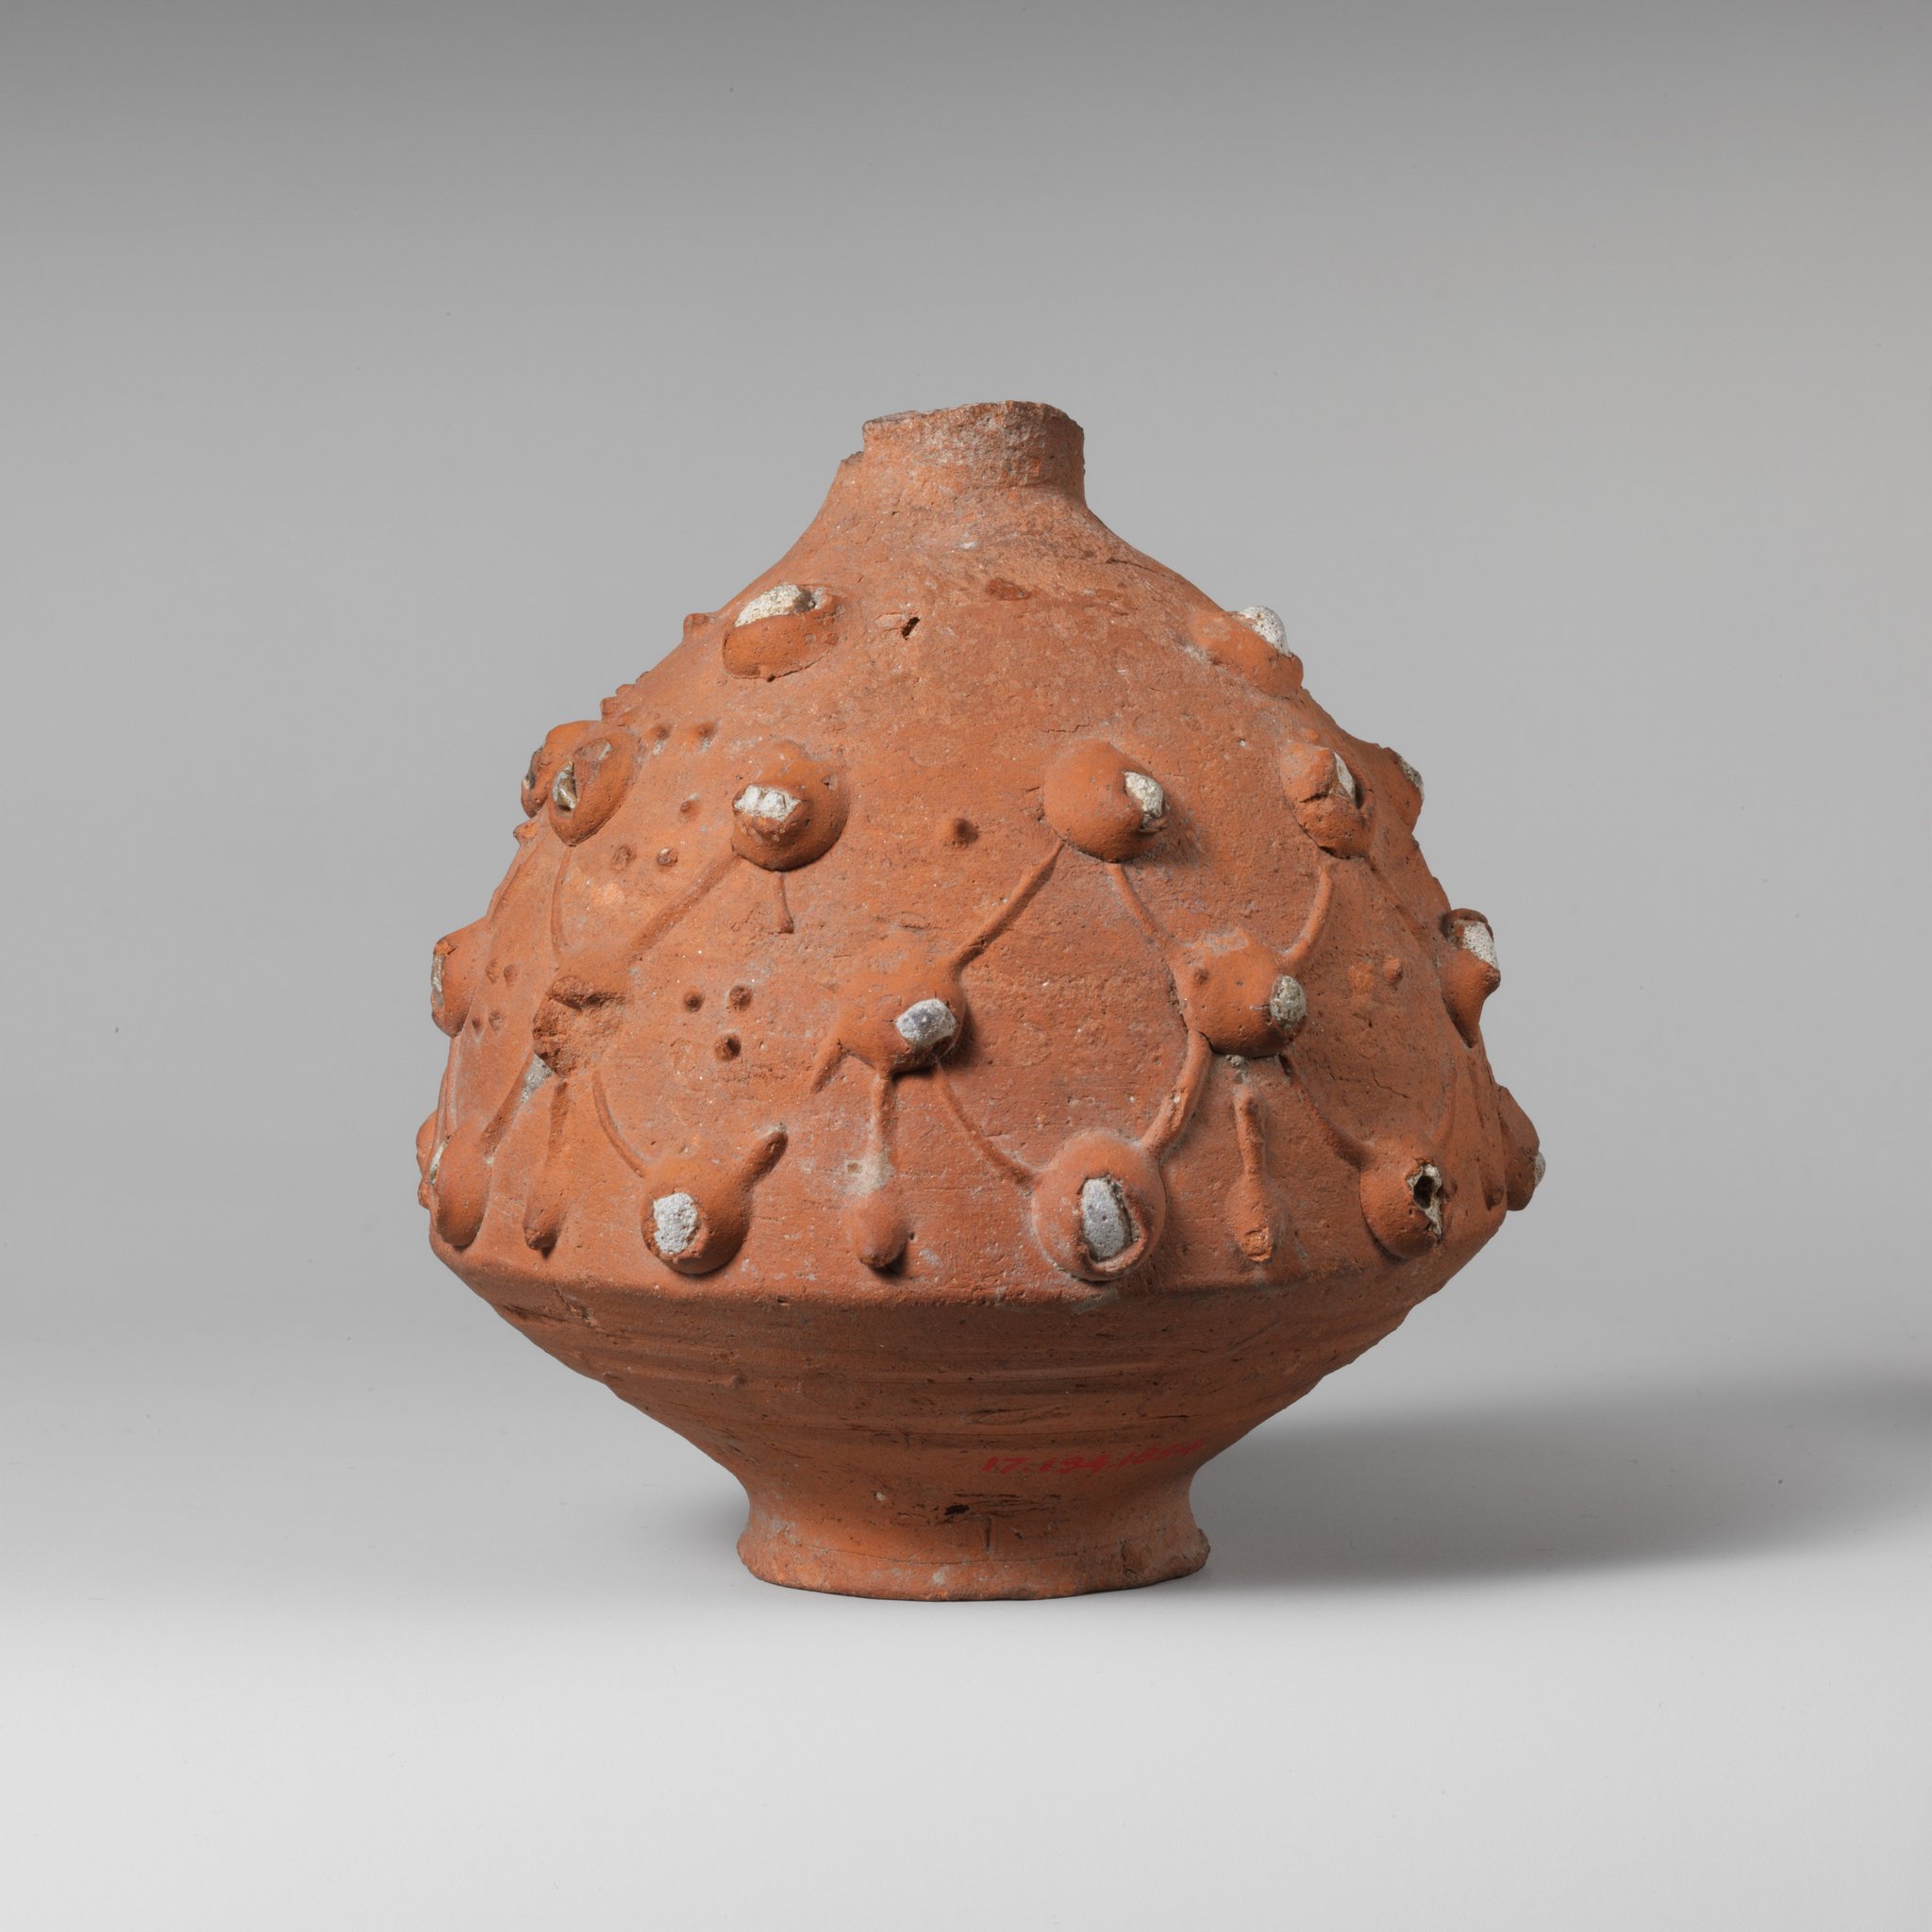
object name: vase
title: Terracotta flask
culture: roman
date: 101-200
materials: glass, terracotta